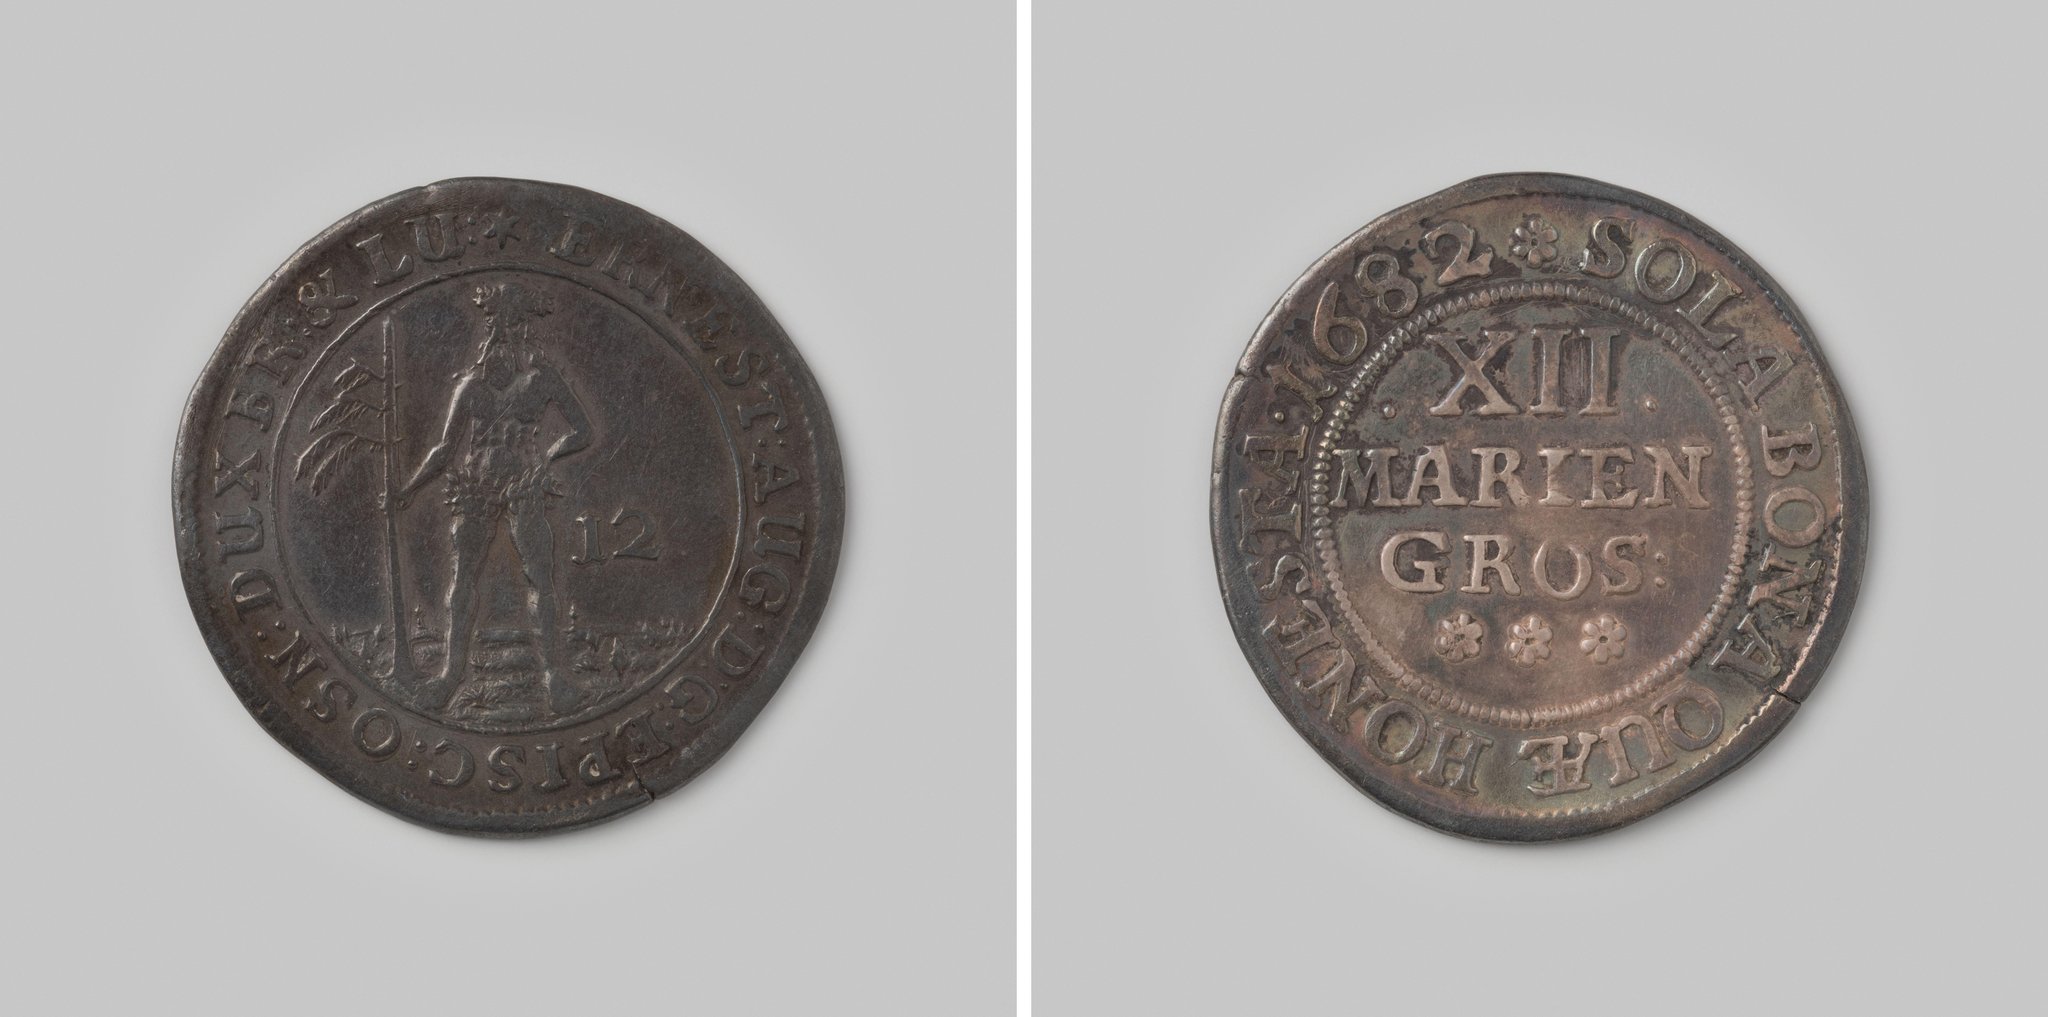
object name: twaalf mariëngroschen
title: Brunswijk-Luneburg-Calenberg, Ernst August, 12 mariëngroschen, 1682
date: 1682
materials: silver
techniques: striking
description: Zilveren munt. Voorzijde: in landschap staande wildeman, met rechterhand denneboom vasthoudend. Cijfer 12 in het veld. Keerzijde: waarde-aanduiding in drie regels. Jaartal in omschrift. Gladde rand.